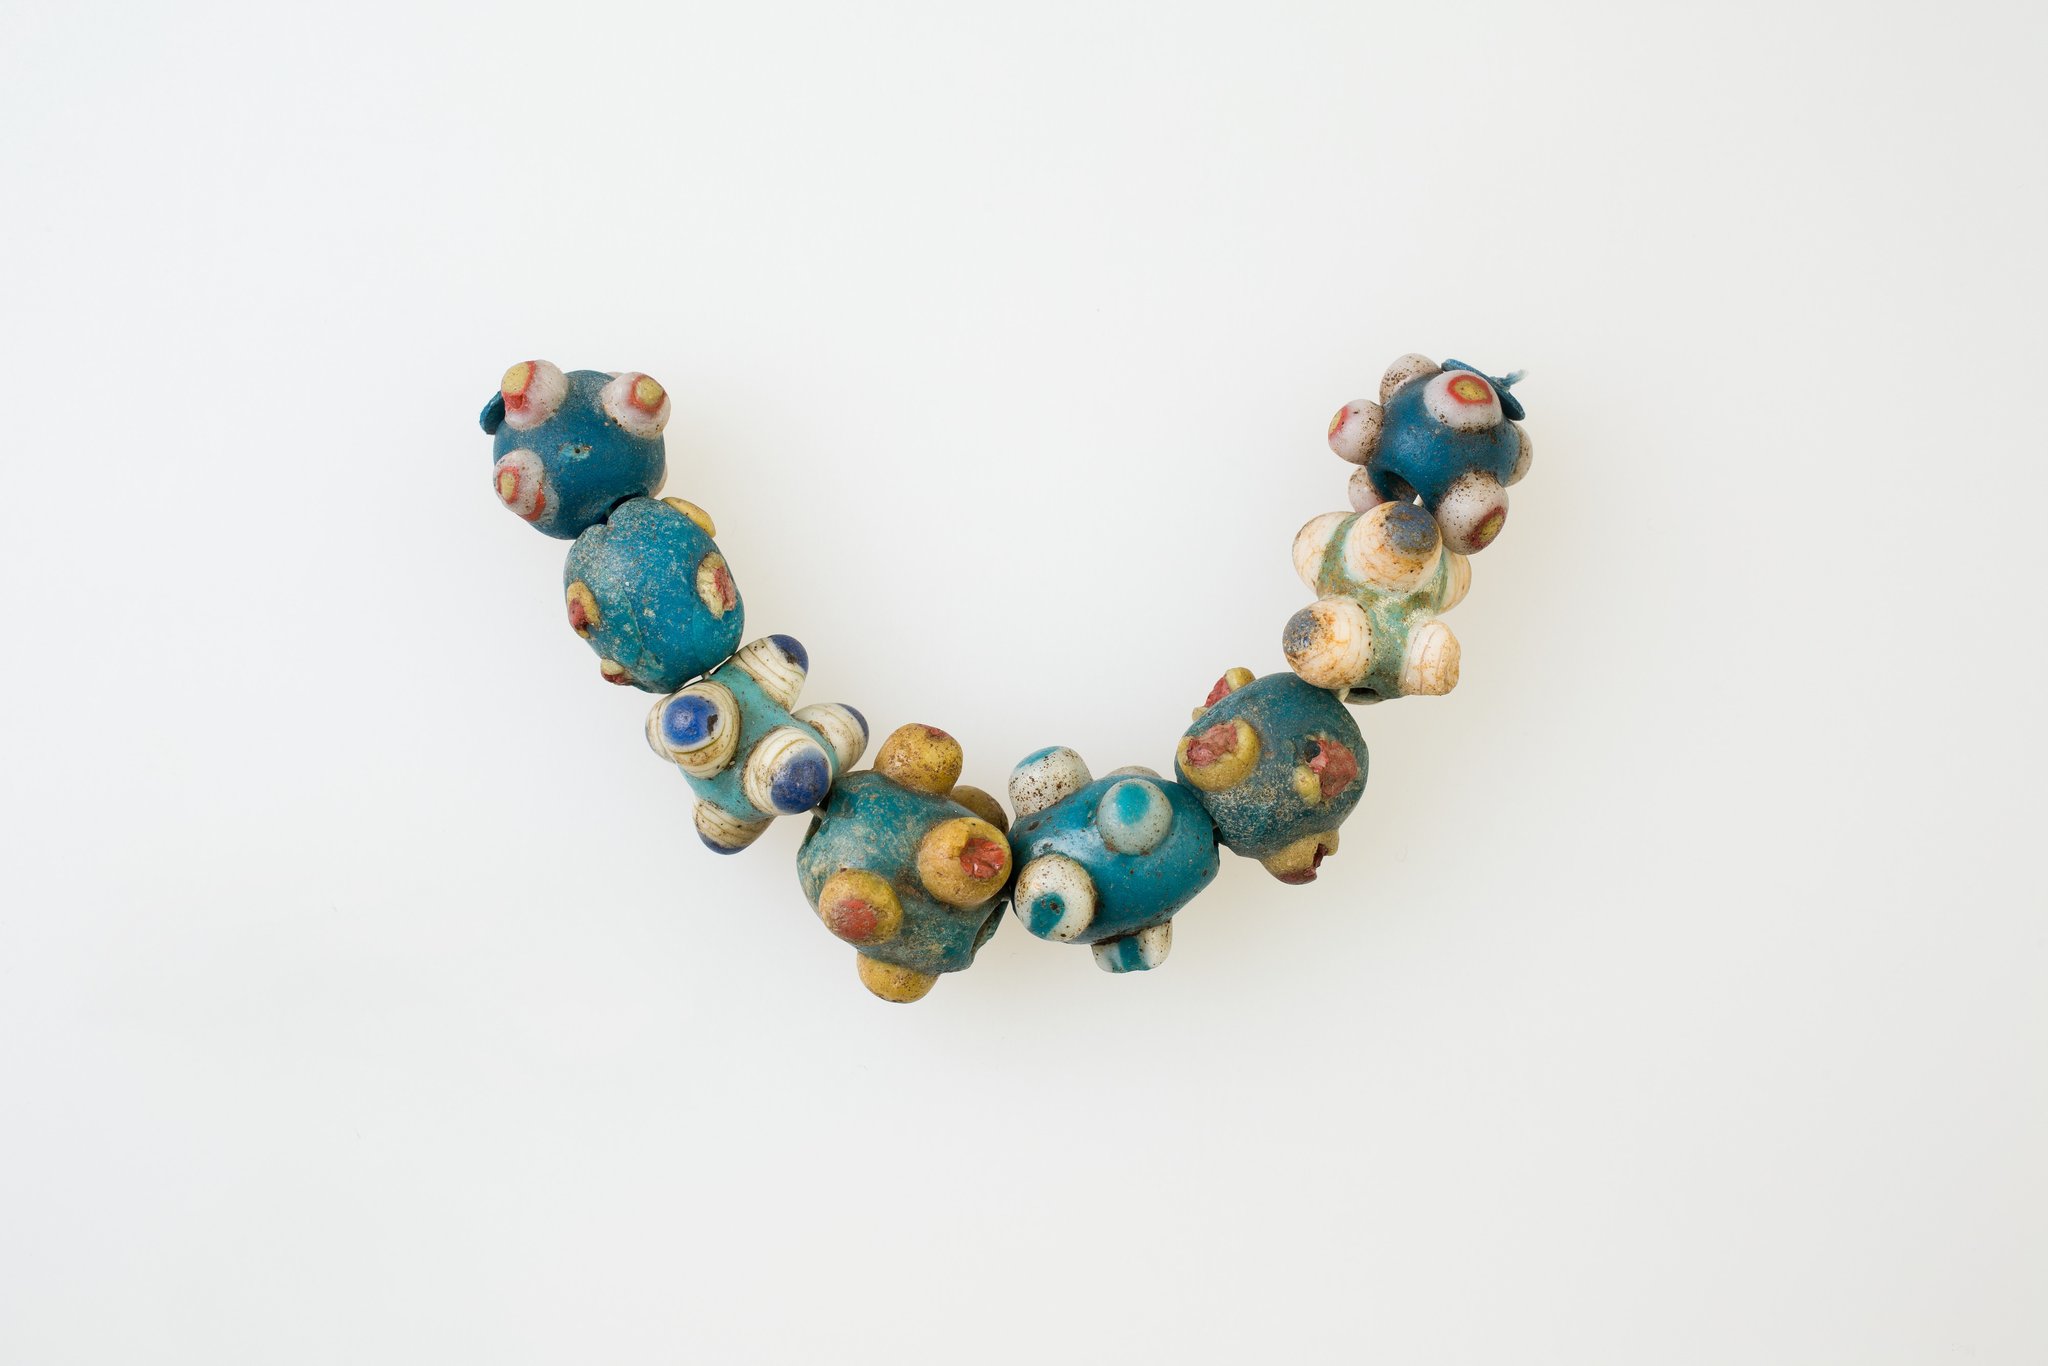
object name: bead, string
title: String of 8 Beads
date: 400-200 BCE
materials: glass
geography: egypt